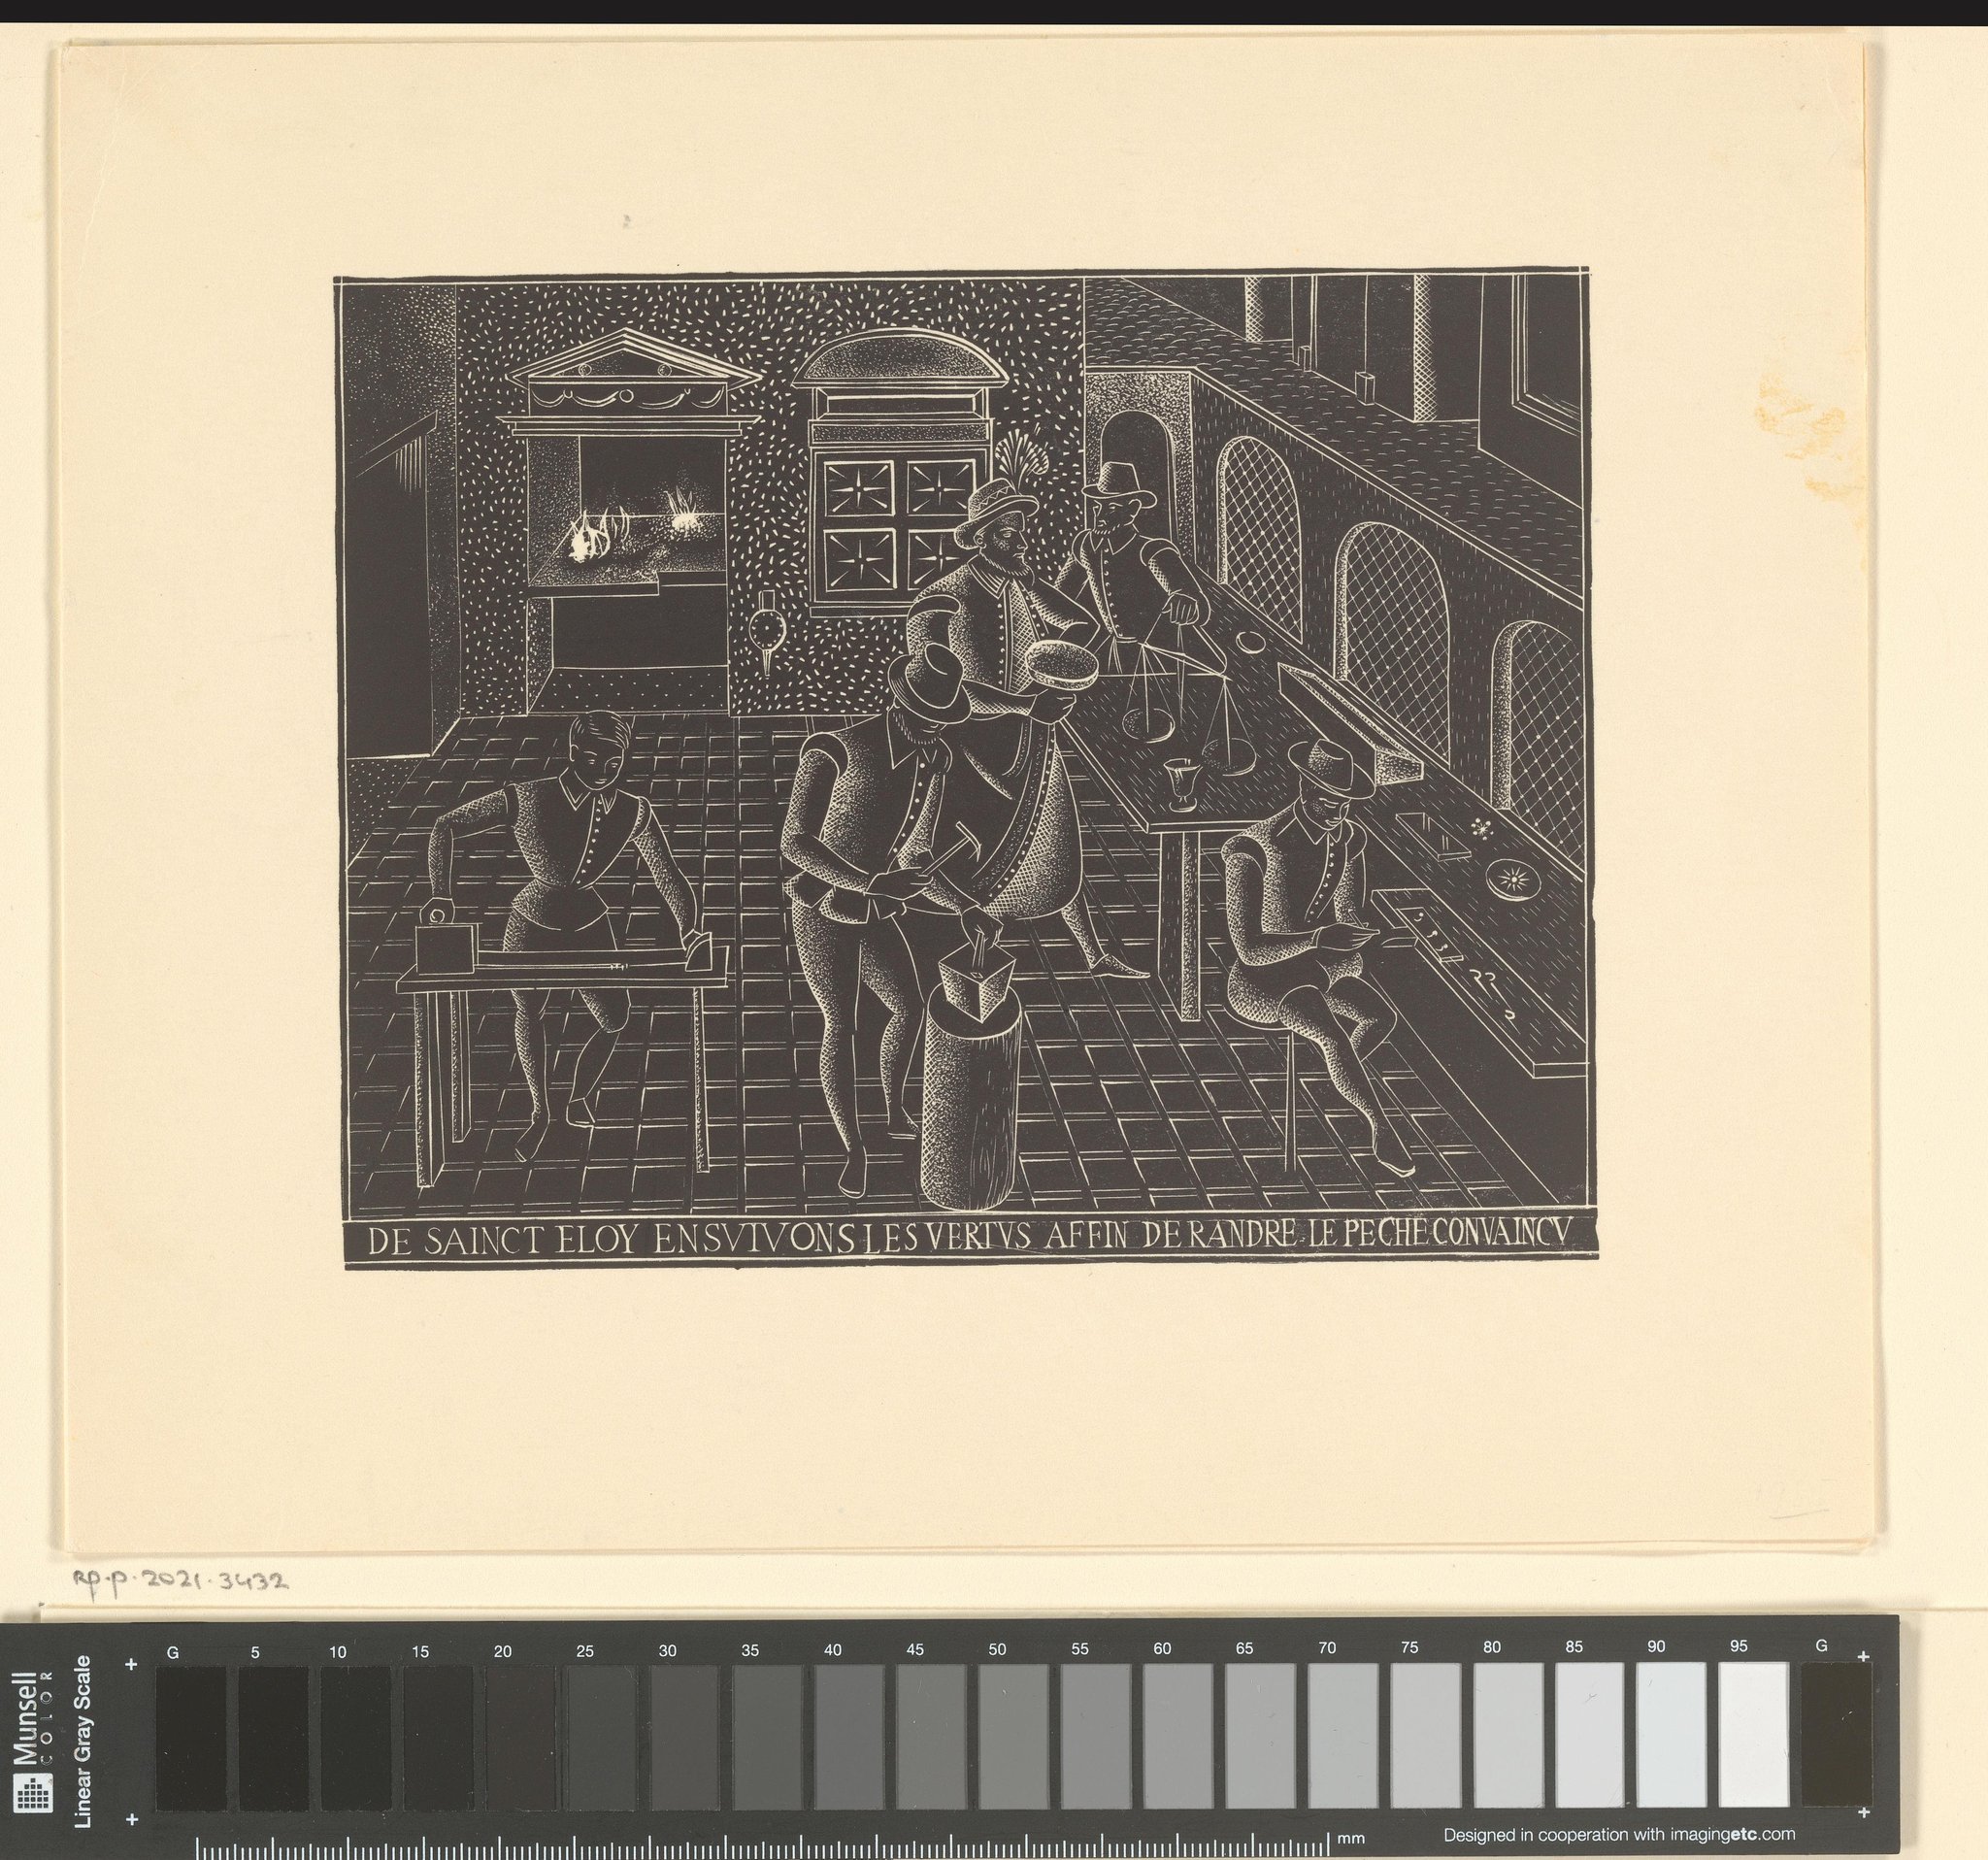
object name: photomechanical print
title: Nieuwjaarswens voor 1955 van juwelier Citroen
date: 1954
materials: paper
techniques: letterpress printing, printing block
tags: amsterdam, jeweller, goldsmith, silversmith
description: Bij gebrek aan gegevens over de vervaardiger is voor de bepaling van de rechten van dit object gebruik gemaakt van de vervaardigingsdatum.